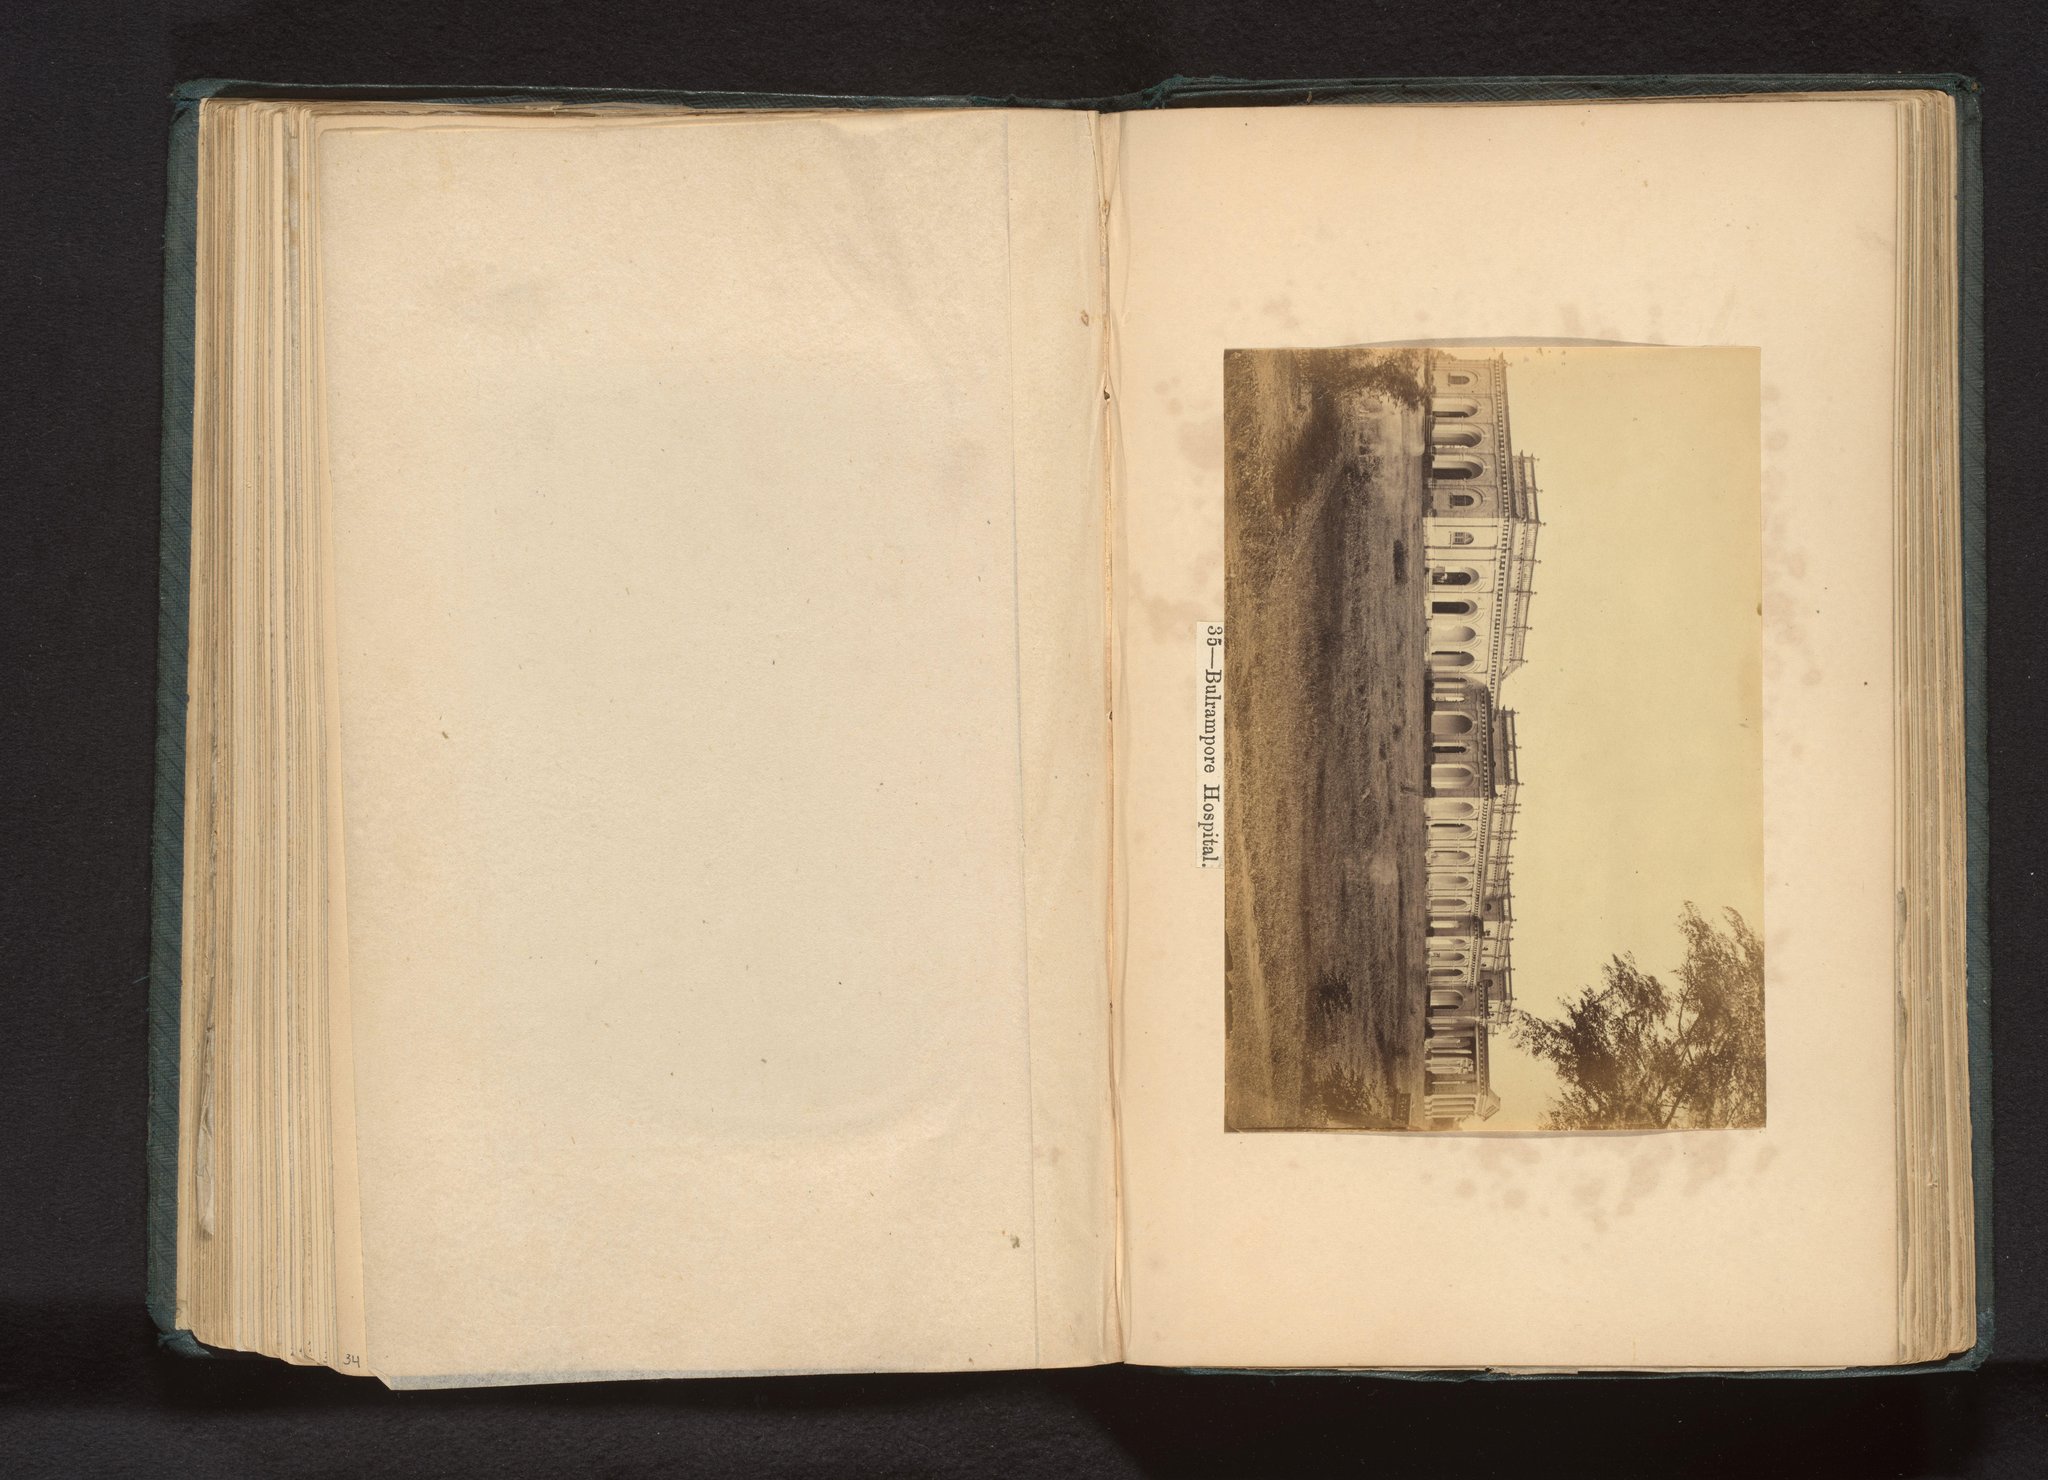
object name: photograph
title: Gezicht op een ziekenhuis in Lucknow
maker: darogha ubbas alli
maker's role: fotograaf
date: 1864-1874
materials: photographic support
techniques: albumen print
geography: lucknow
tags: hospital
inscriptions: number: ‘35’